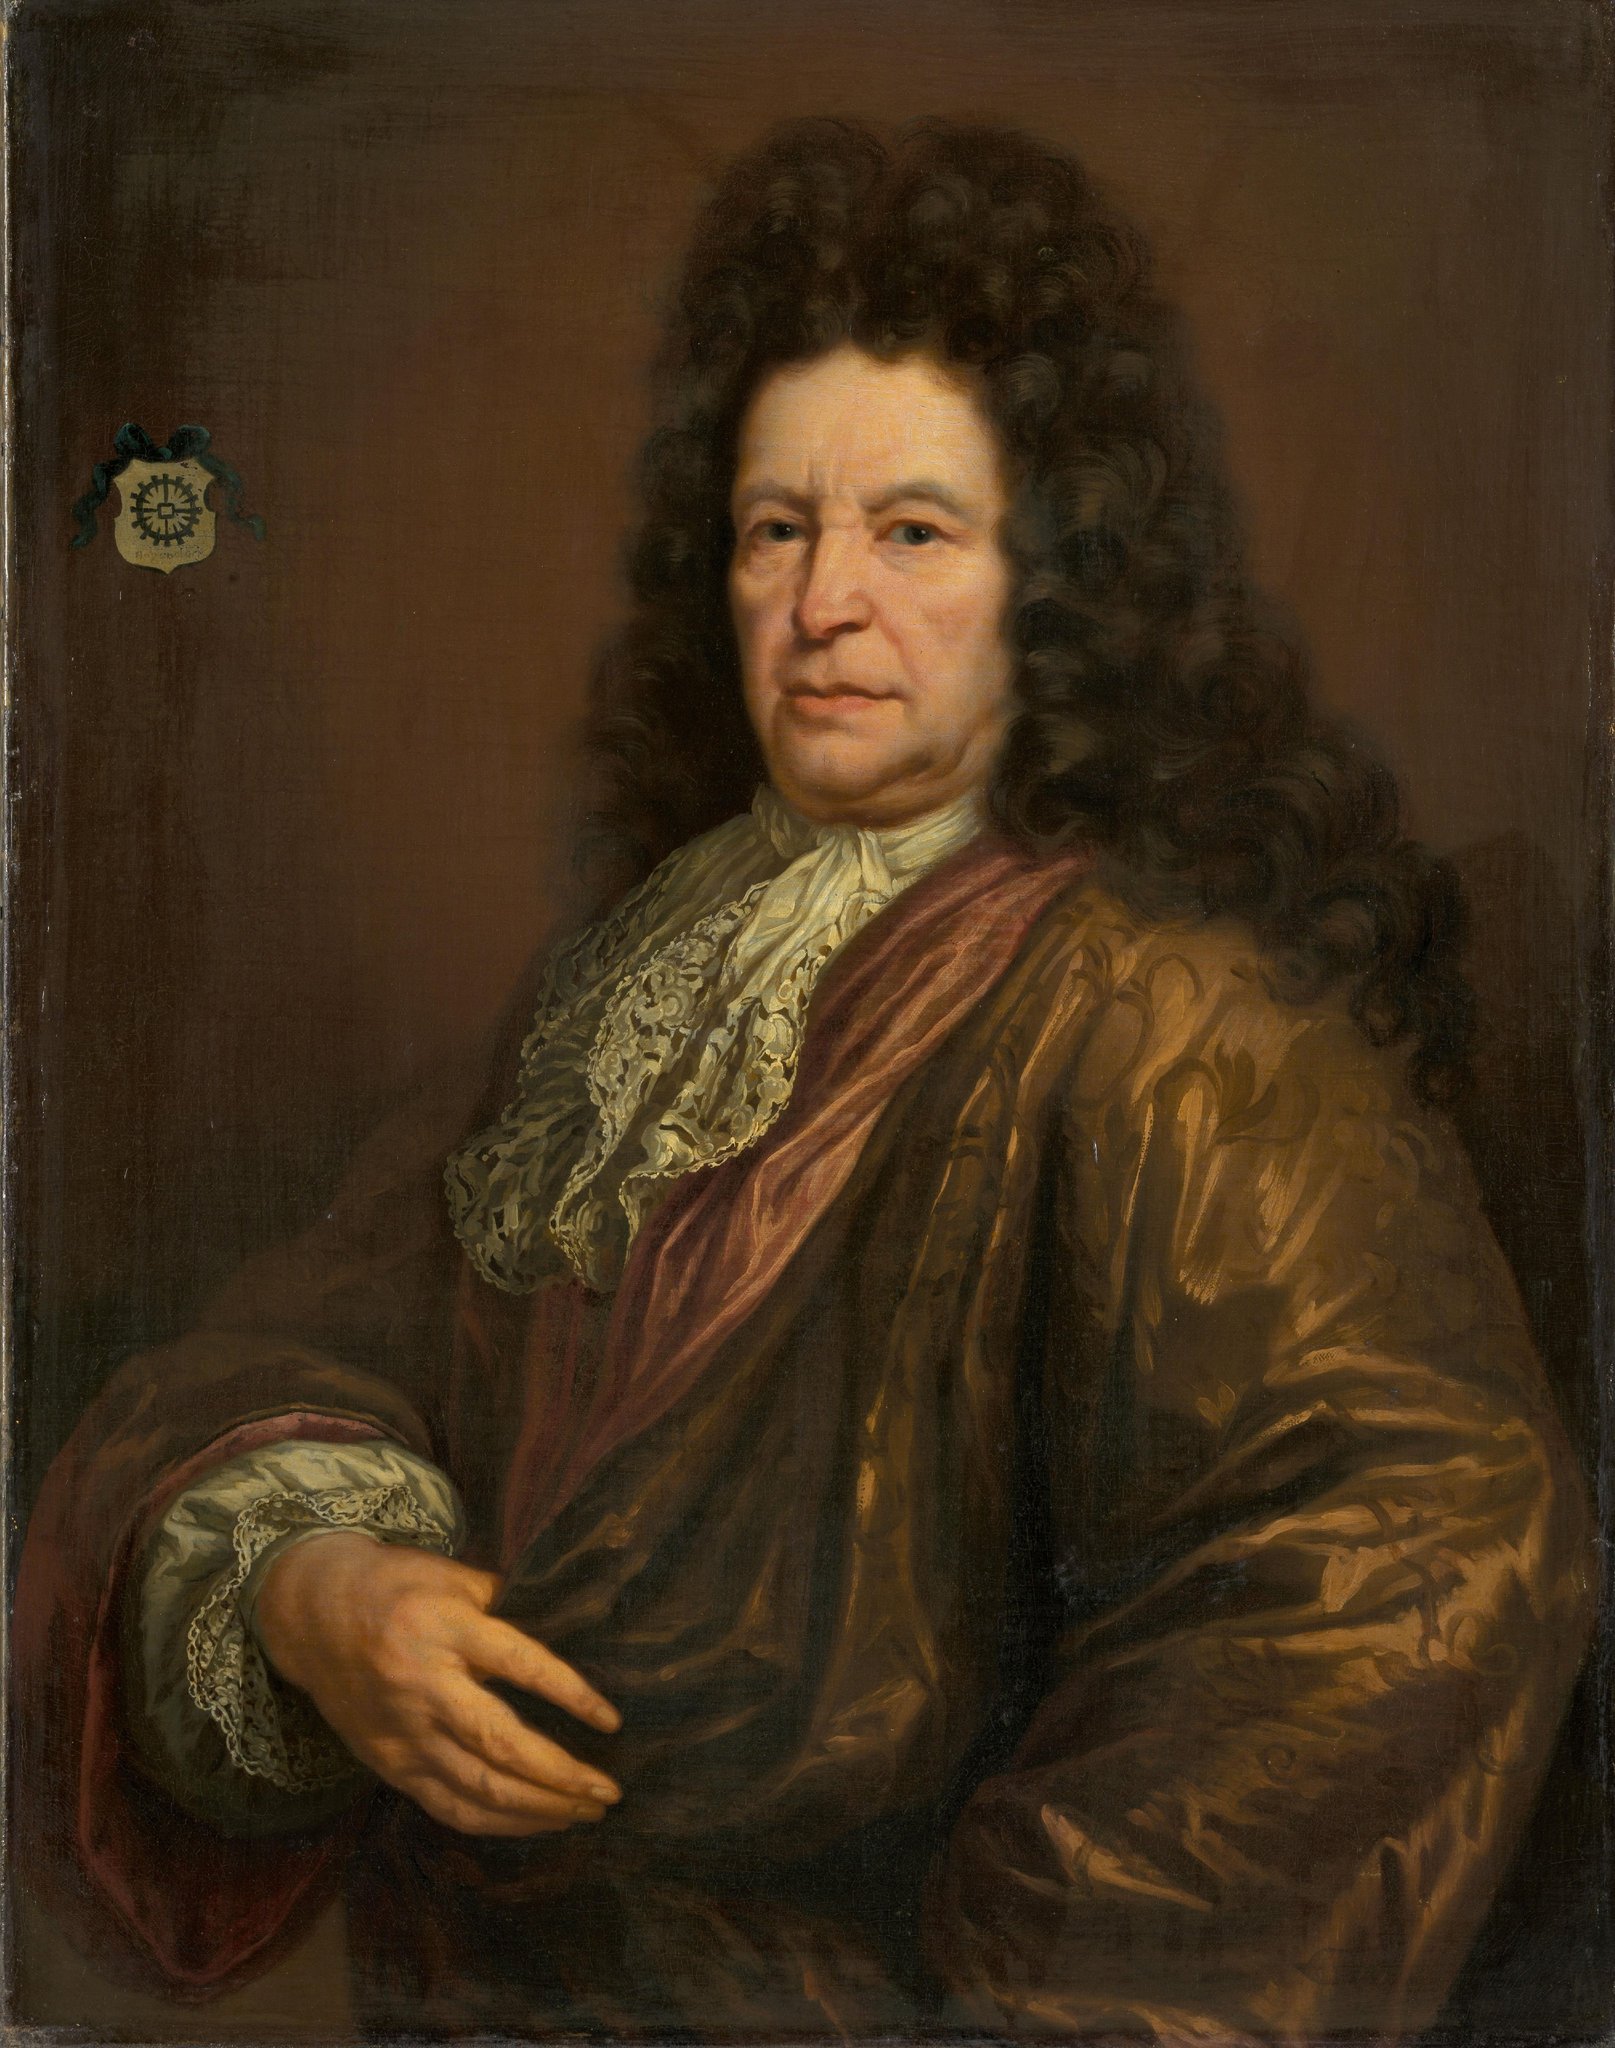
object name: painting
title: Portrait of Diederik van Hogendorp (1625-1702)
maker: Anonymous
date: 1690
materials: canvas, oil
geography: netherlands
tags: the hague, historical persons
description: Portret van Diederik van Hogendorp (1625-1702). Heer van Cromstrijen. Raad en rekenmeester der domeinen van de stadhouder-koning Willem III. Ten halven lijve naar links, in japonsche rock. Linksboven het familiewapen. Pendant van SK-A-821.